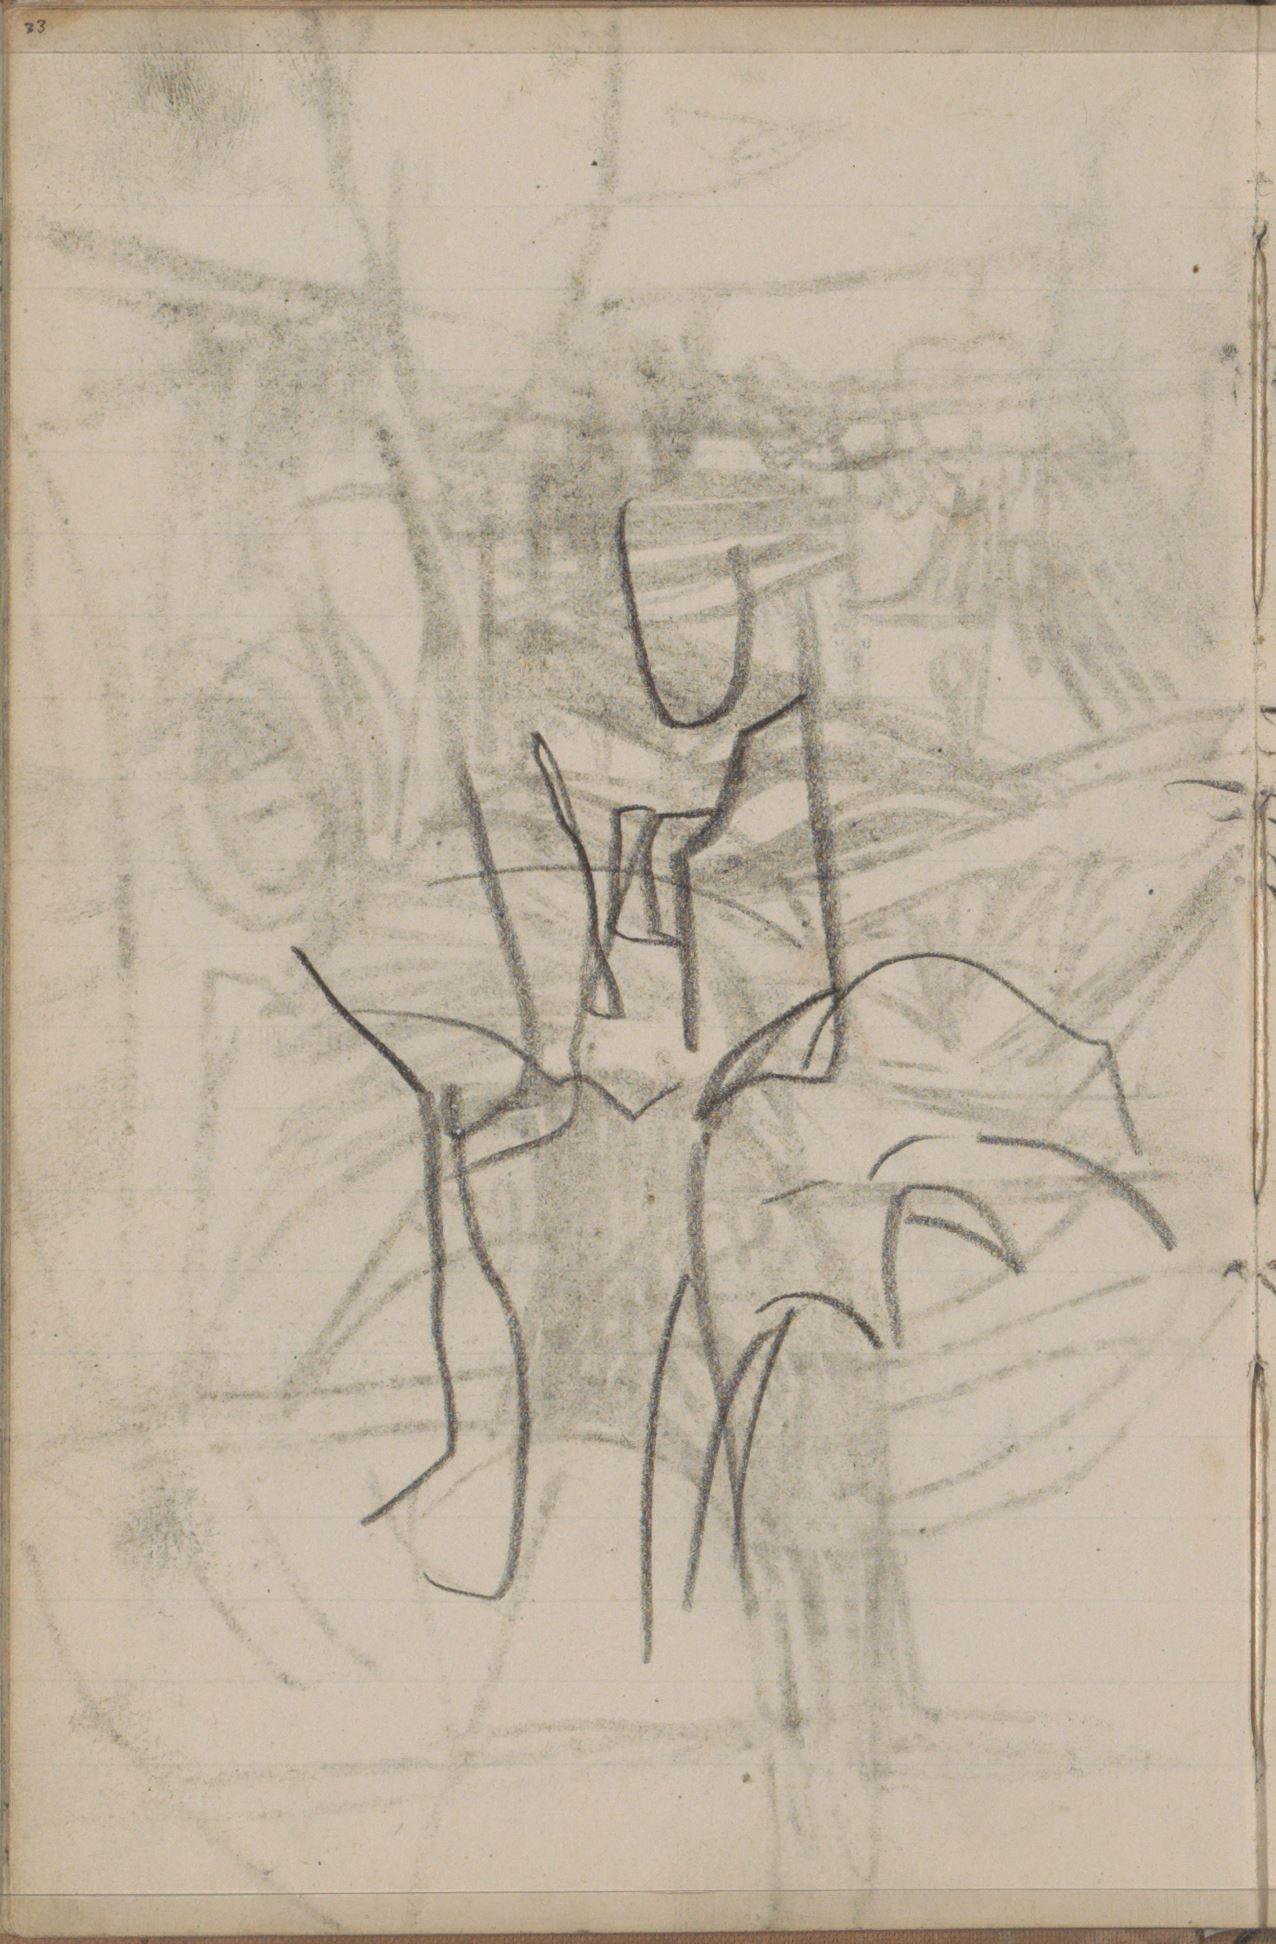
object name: sketchbook leaf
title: Studieblad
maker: marius bauer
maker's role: draughtsman, print maker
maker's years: 1867-1932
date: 1888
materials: chalk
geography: istanbul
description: Pagina 33 uit een schetsboek met 56 bladen.